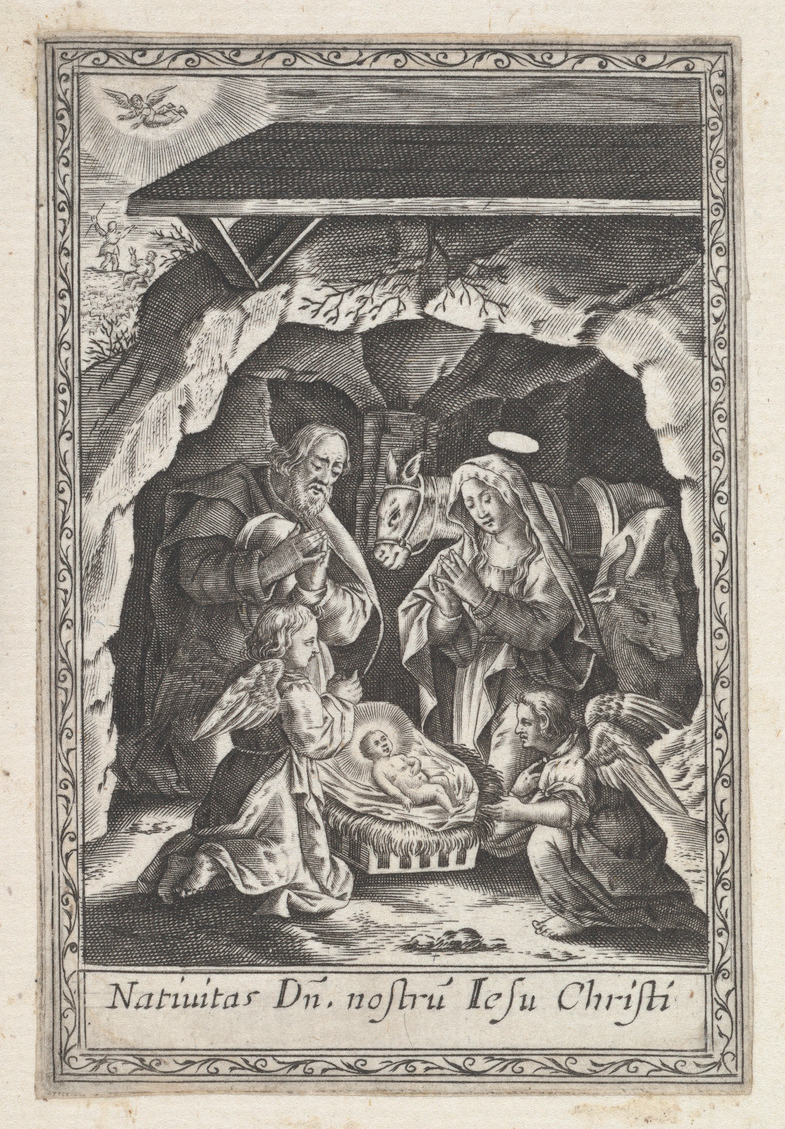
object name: print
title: The Nativity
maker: Anonymous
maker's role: artist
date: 1590-1620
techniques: engraving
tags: angels,christ,virgin mary,nativity